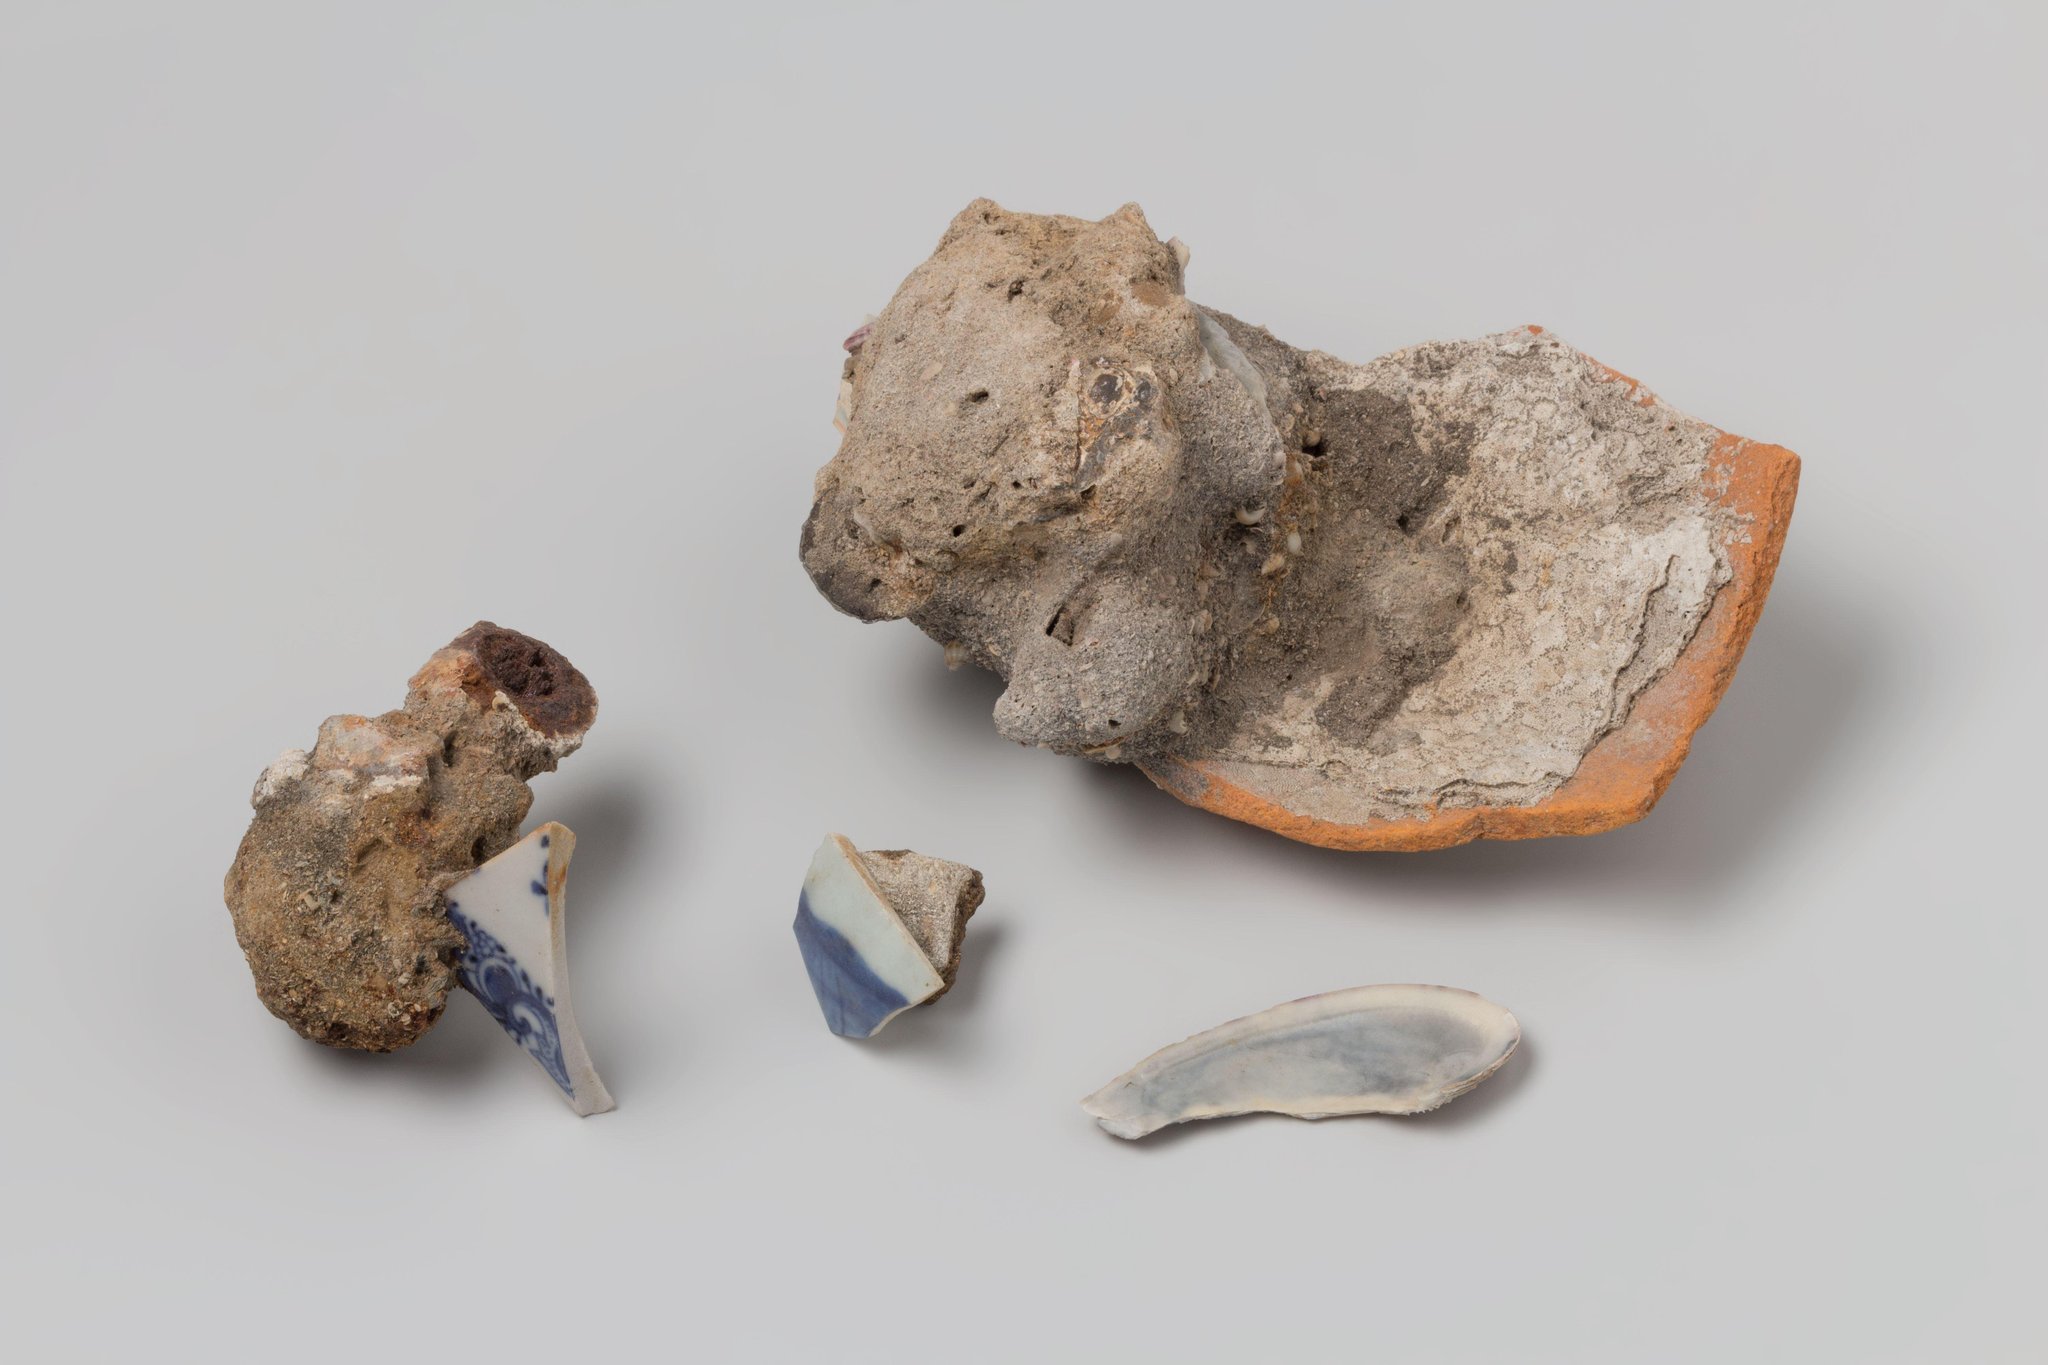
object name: sherd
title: Scherven van porselein en aardewerk uit V.O.C.-schip de 'Witte Leeuw'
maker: Anonymous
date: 1613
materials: coral, earthenware, porcelain, shell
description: Scherven van porselein en roodbakkend aardewerk met aankoeksels van de zeebodem uit V.O.C.-schip de 'Witte Leeuw'.